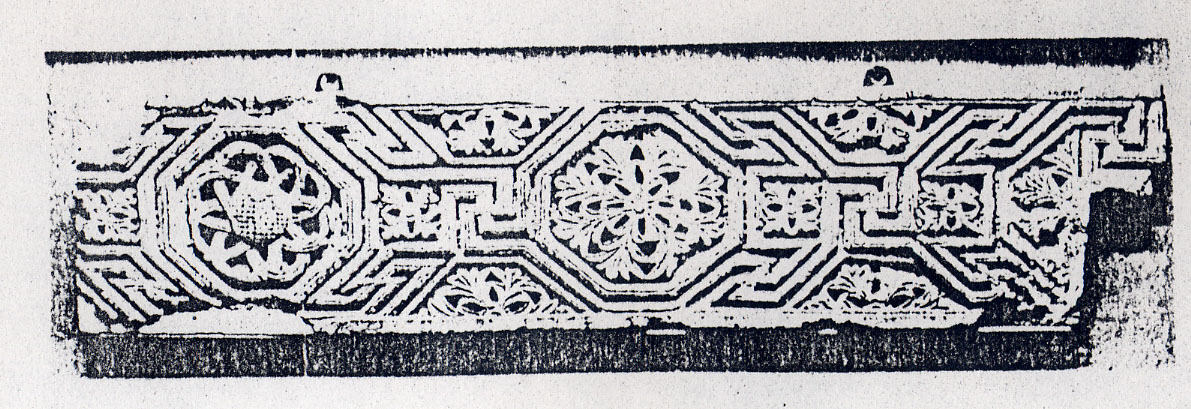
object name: frieze fragment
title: Fragment from a Frieze with Meander Pattern and Rosettes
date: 500-599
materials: limestone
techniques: carving, relief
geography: egypt